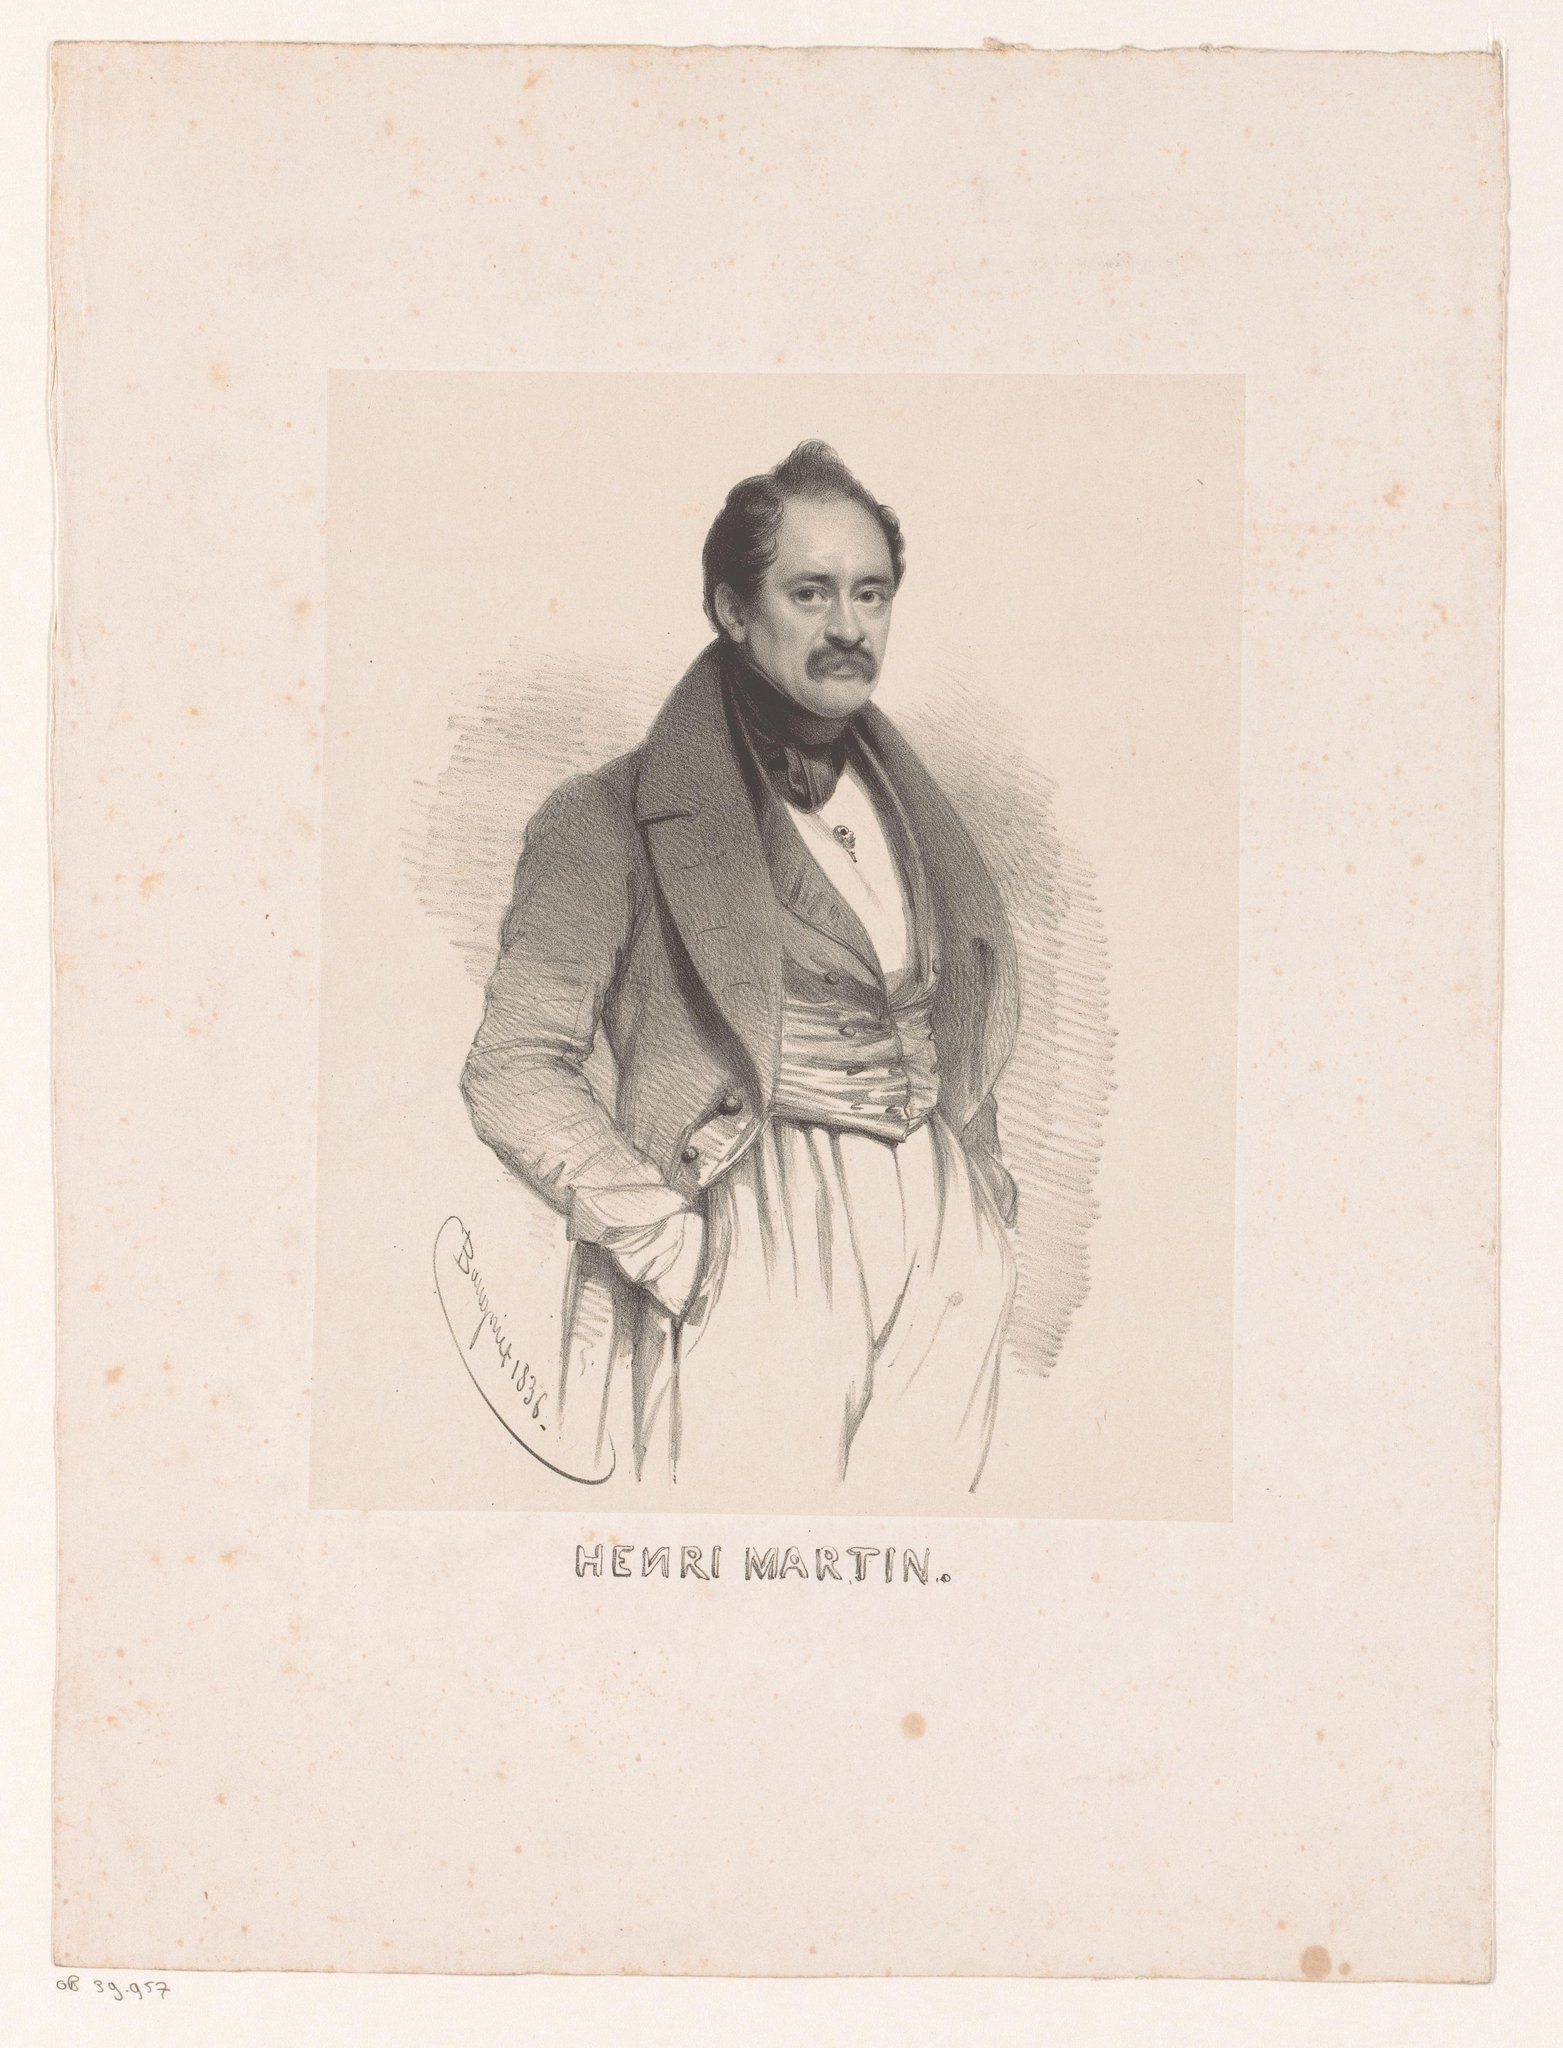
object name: print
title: Portret van Henri Martin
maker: charles baugniet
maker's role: print maker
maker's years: 1814-1886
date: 1836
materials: paper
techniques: lithograph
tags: marseille, rotterdam, hand in the pocket - aa - both arms or hands, moustache, adult man, historical persons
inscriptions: collector's mark: Lugt 2228